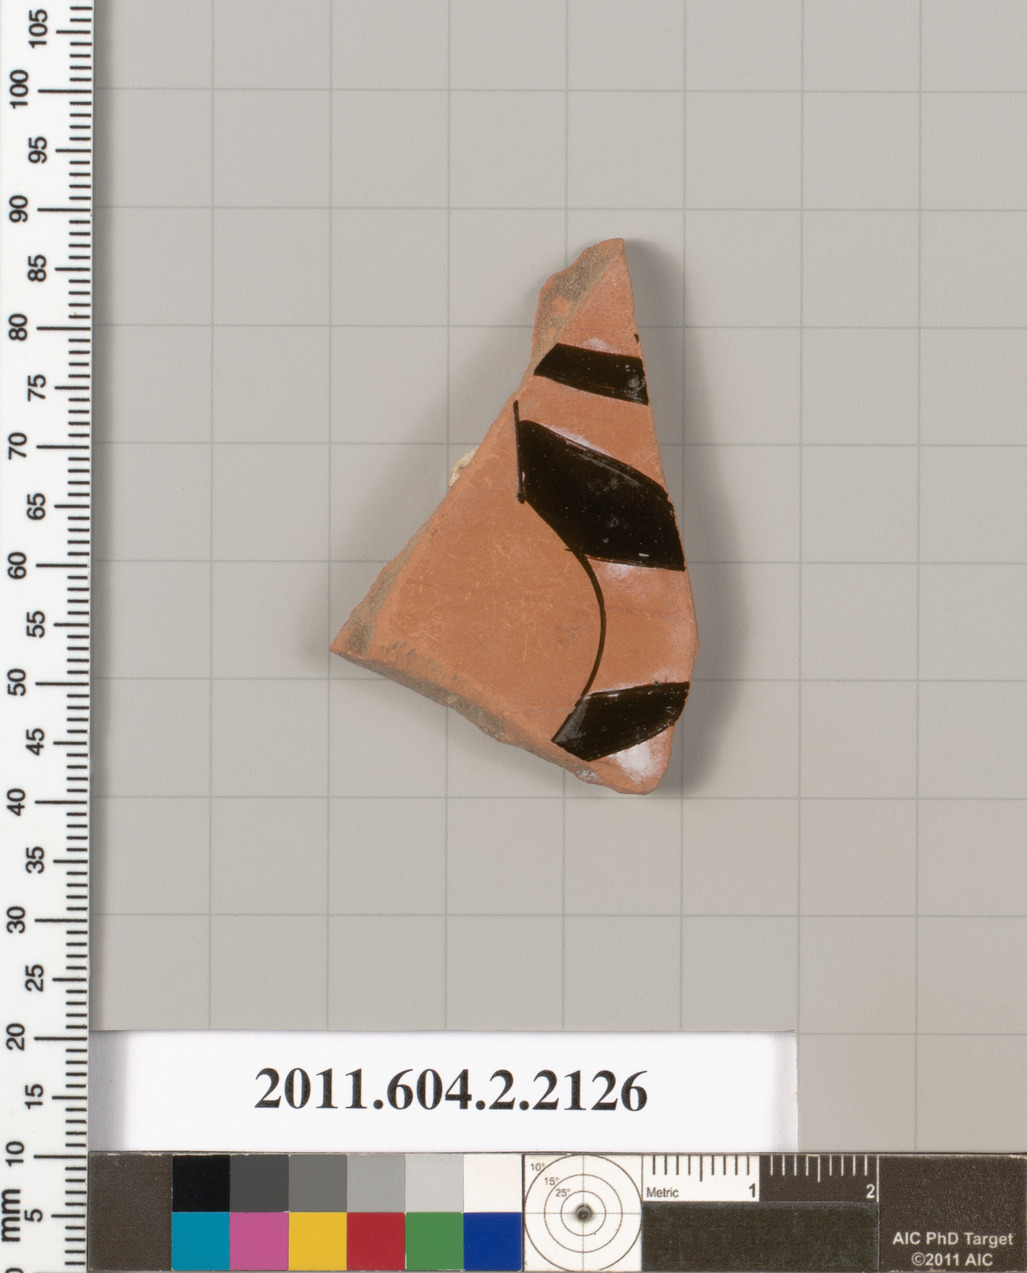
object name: pot fragment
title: Terracotta fragment of a pot; glazed on the inside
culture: greek, attic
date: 475-451 BCE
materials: terracotta